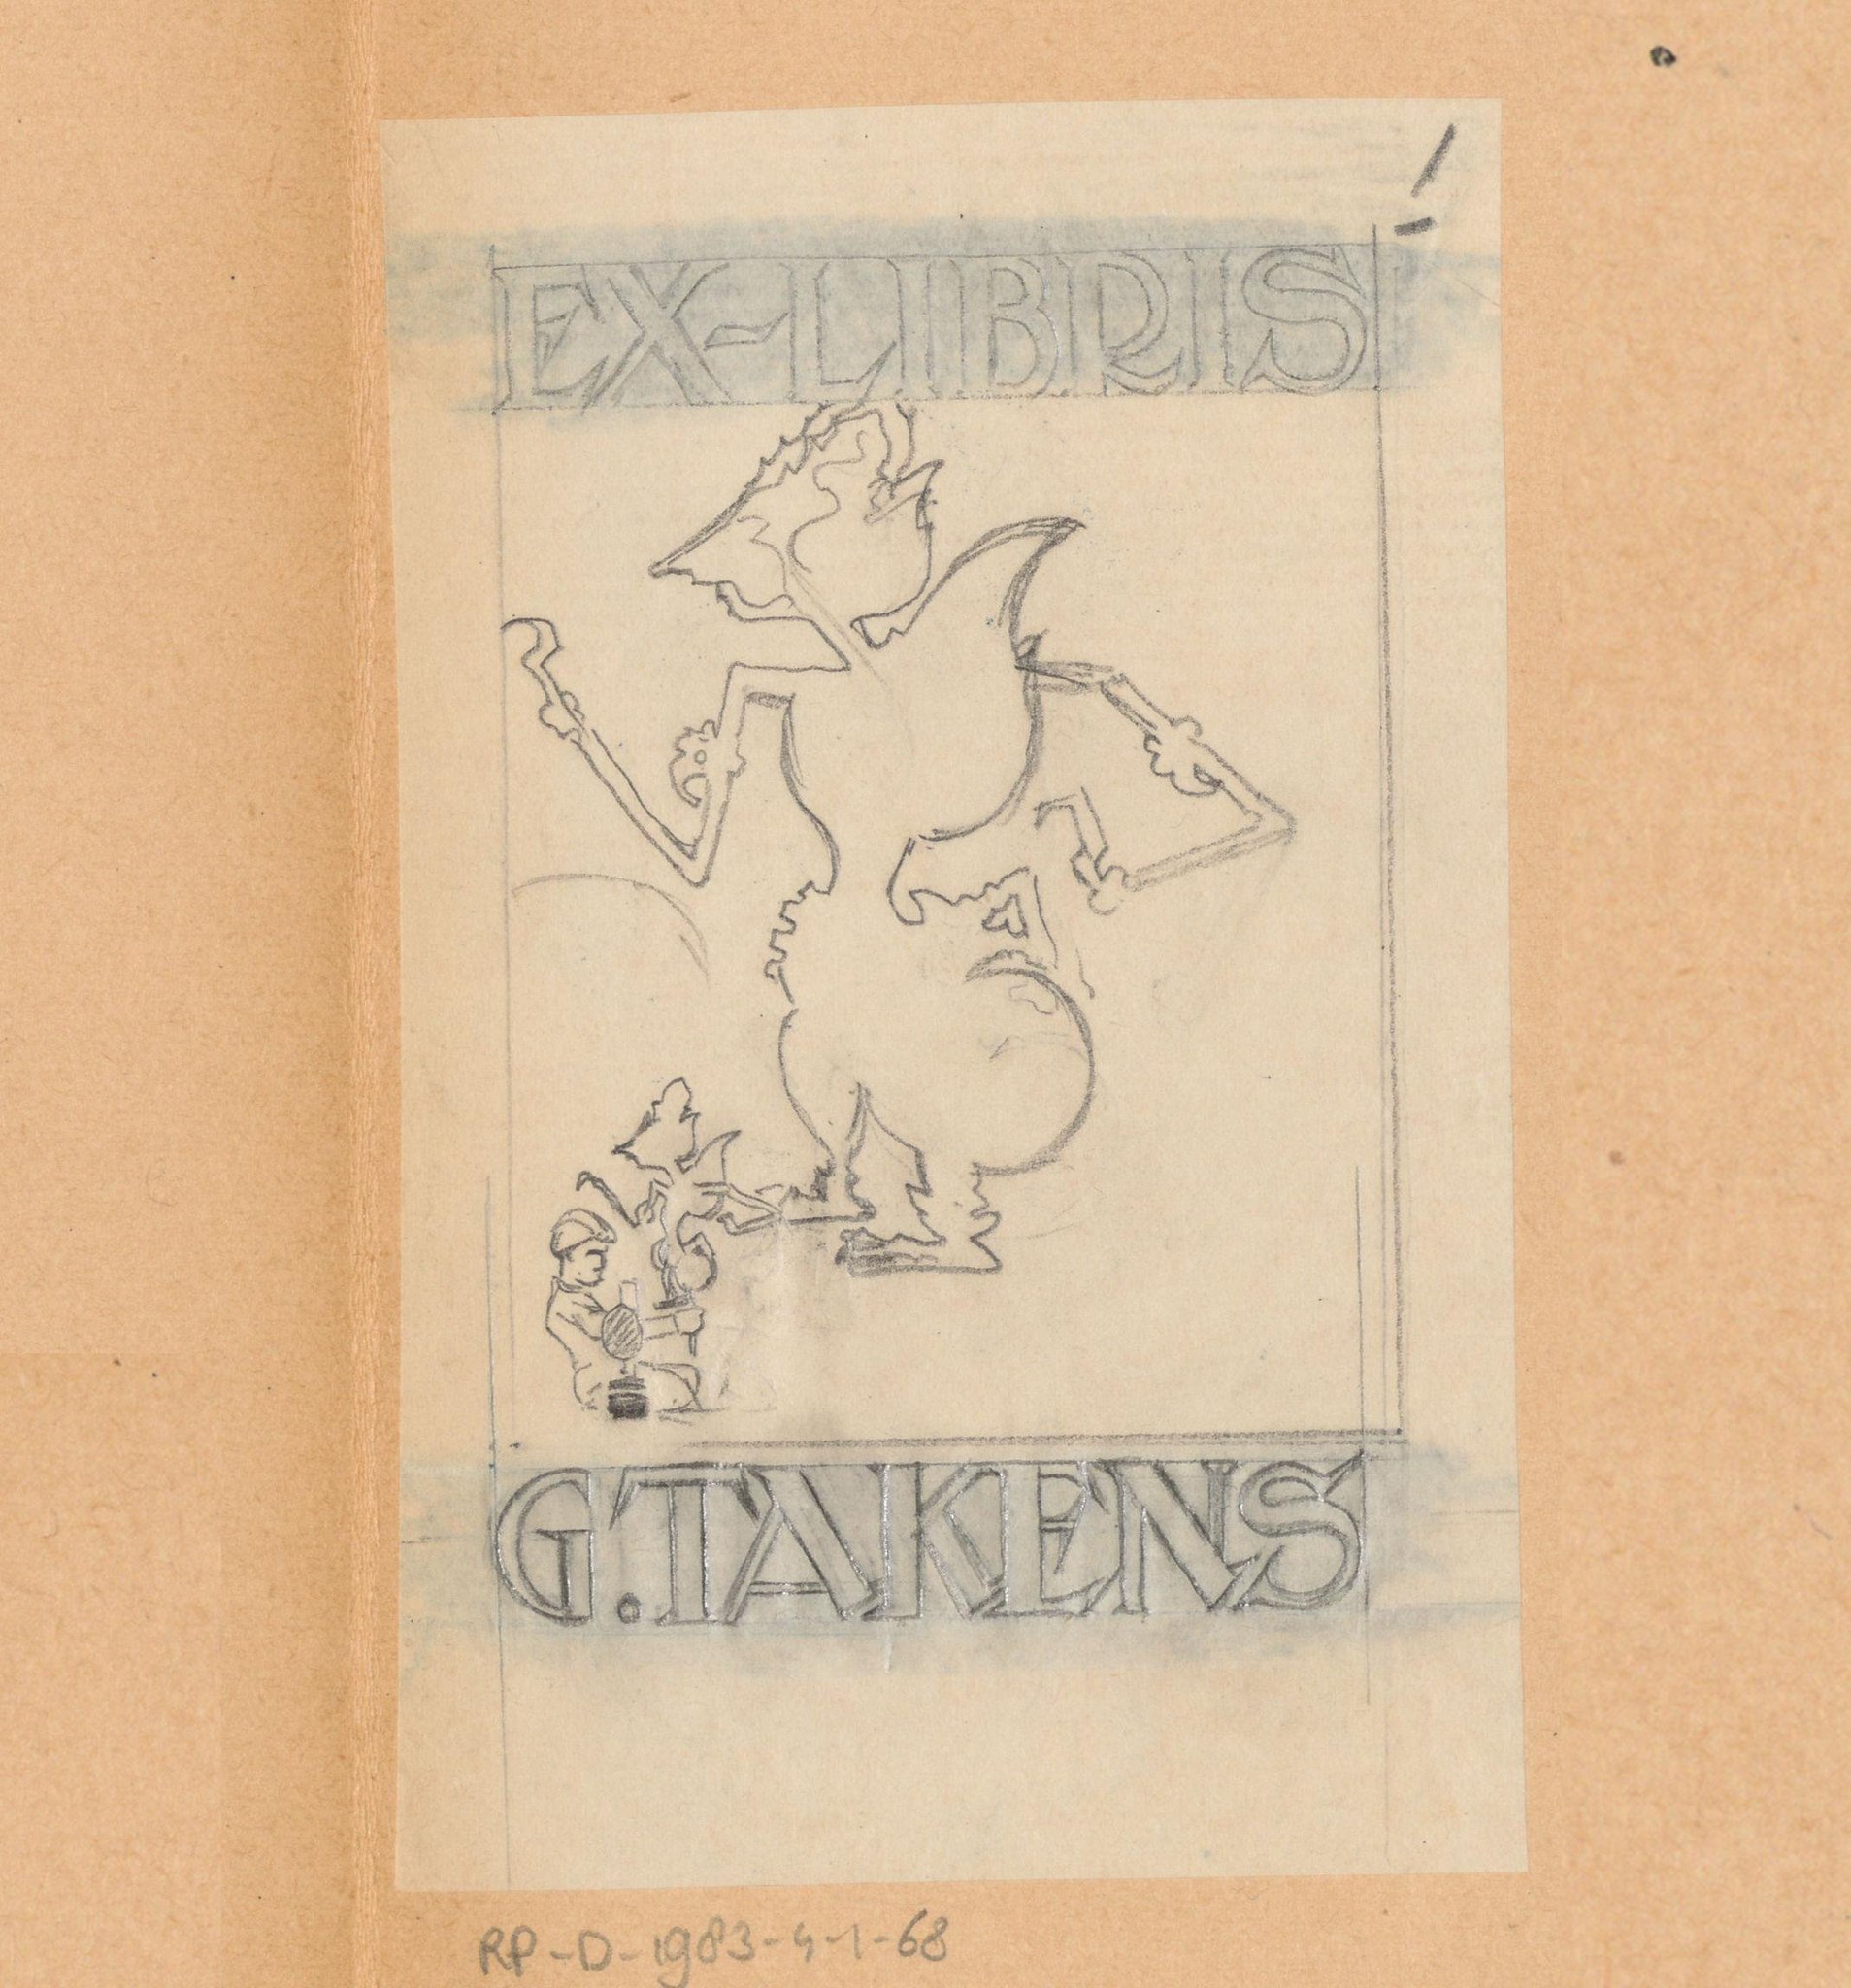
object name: design drawing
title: Ex-libris G. Takens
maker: otto verhagen (i)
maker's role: draughtsman, print maker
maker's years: 1885-1951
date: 1932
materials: paper, pencil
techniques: drawing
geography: netherlands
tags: shadow-play, puppet and marionette show, indonesia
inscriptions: inscription: ‘1’